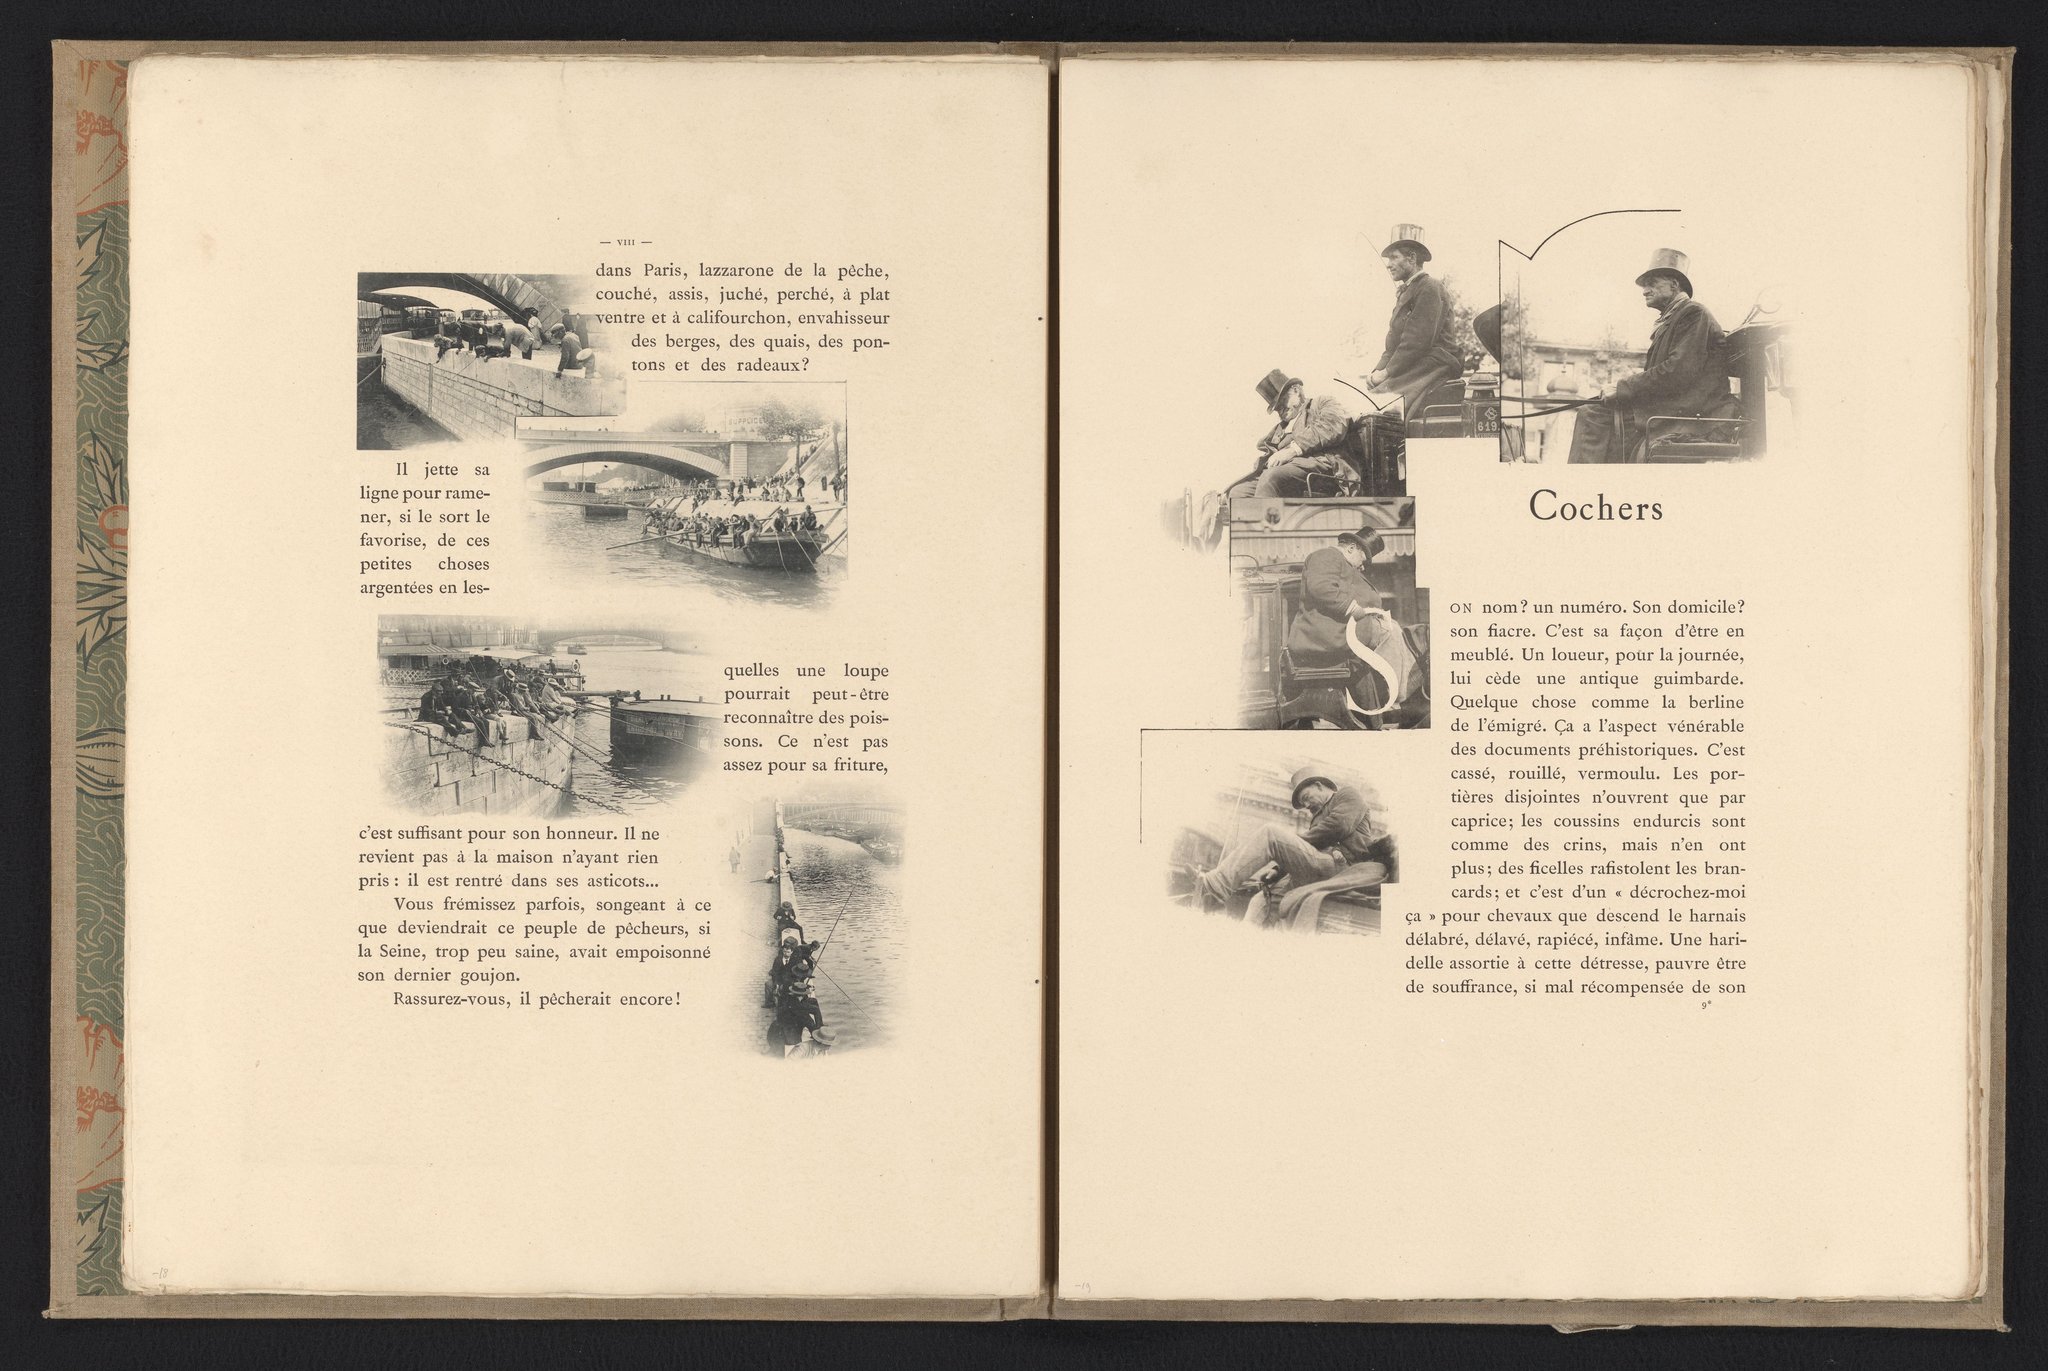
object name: album leaf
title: Á travers les rues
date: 1896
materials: paper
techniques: photograph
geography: châteaudun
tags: four-wheeled, animal-drawn vehicle, e.g.: cab, carriage, coach, paris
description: Prenten op eenendertigste ongenummerde pagina.